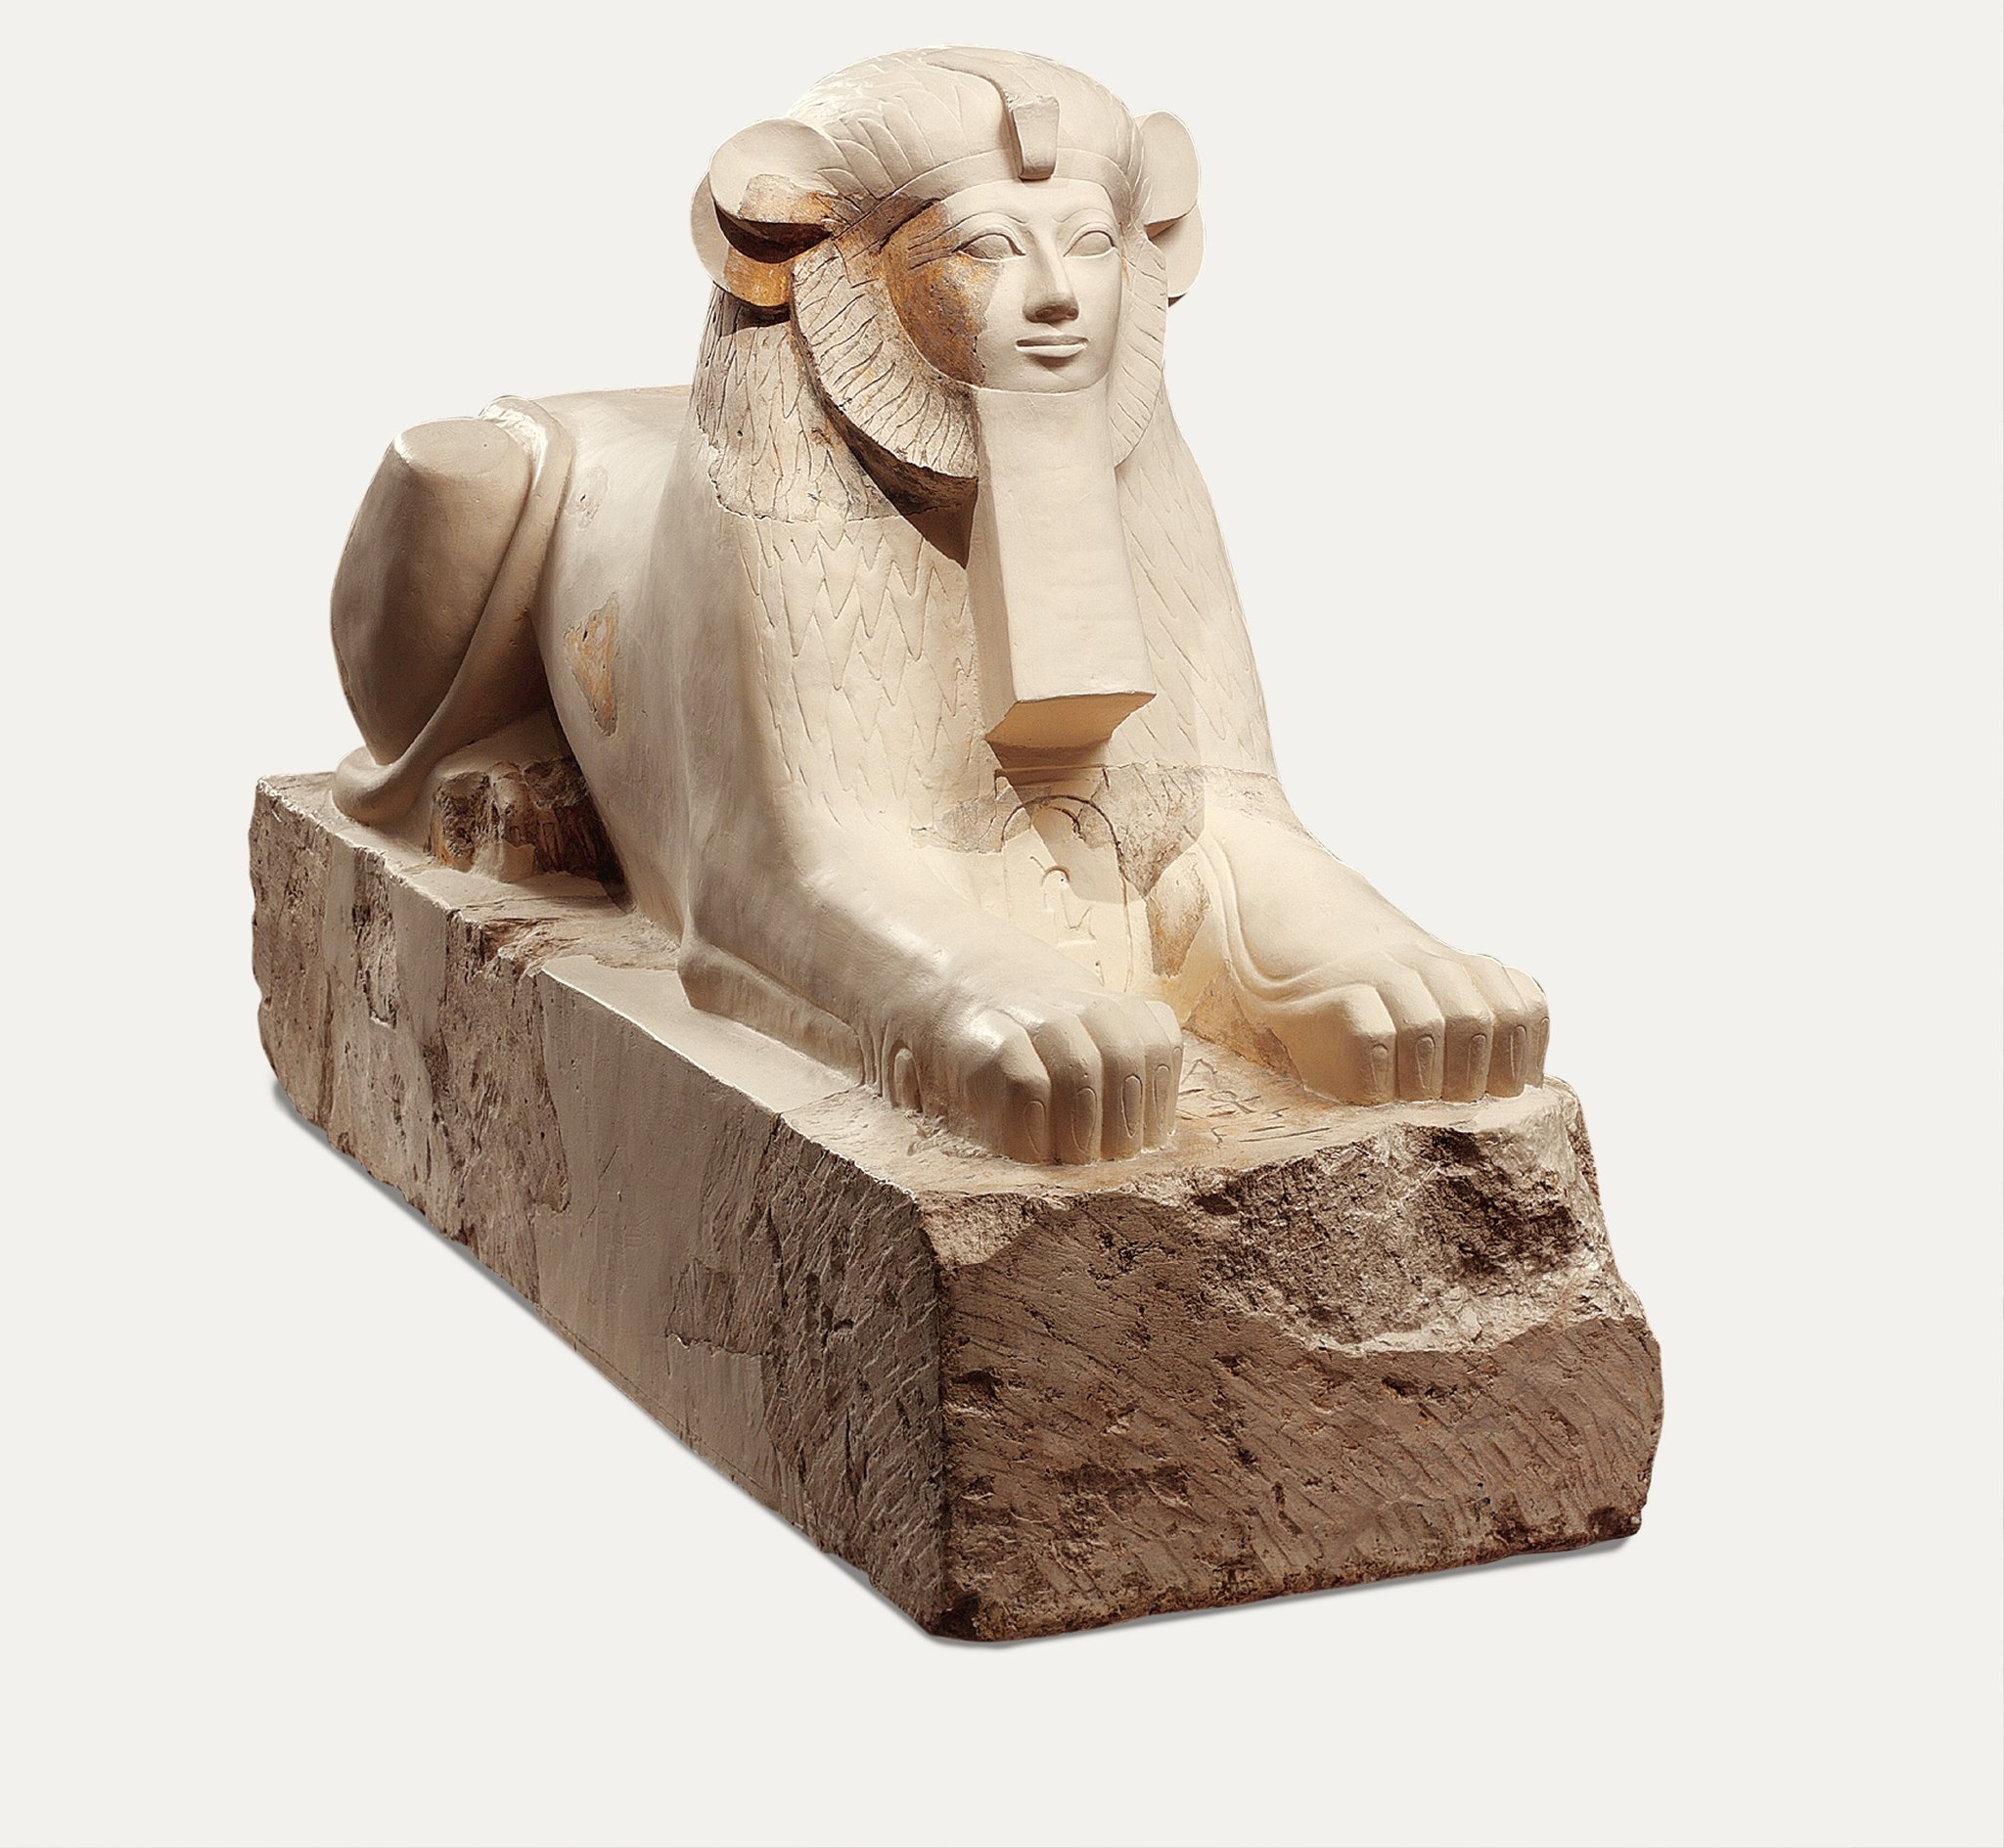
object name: sphinx, hatshepsut, maned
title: Sphinx of Hatshepsut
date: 1479-1458 BCE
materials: limestone, plaster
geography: egypt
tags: women,sphinx